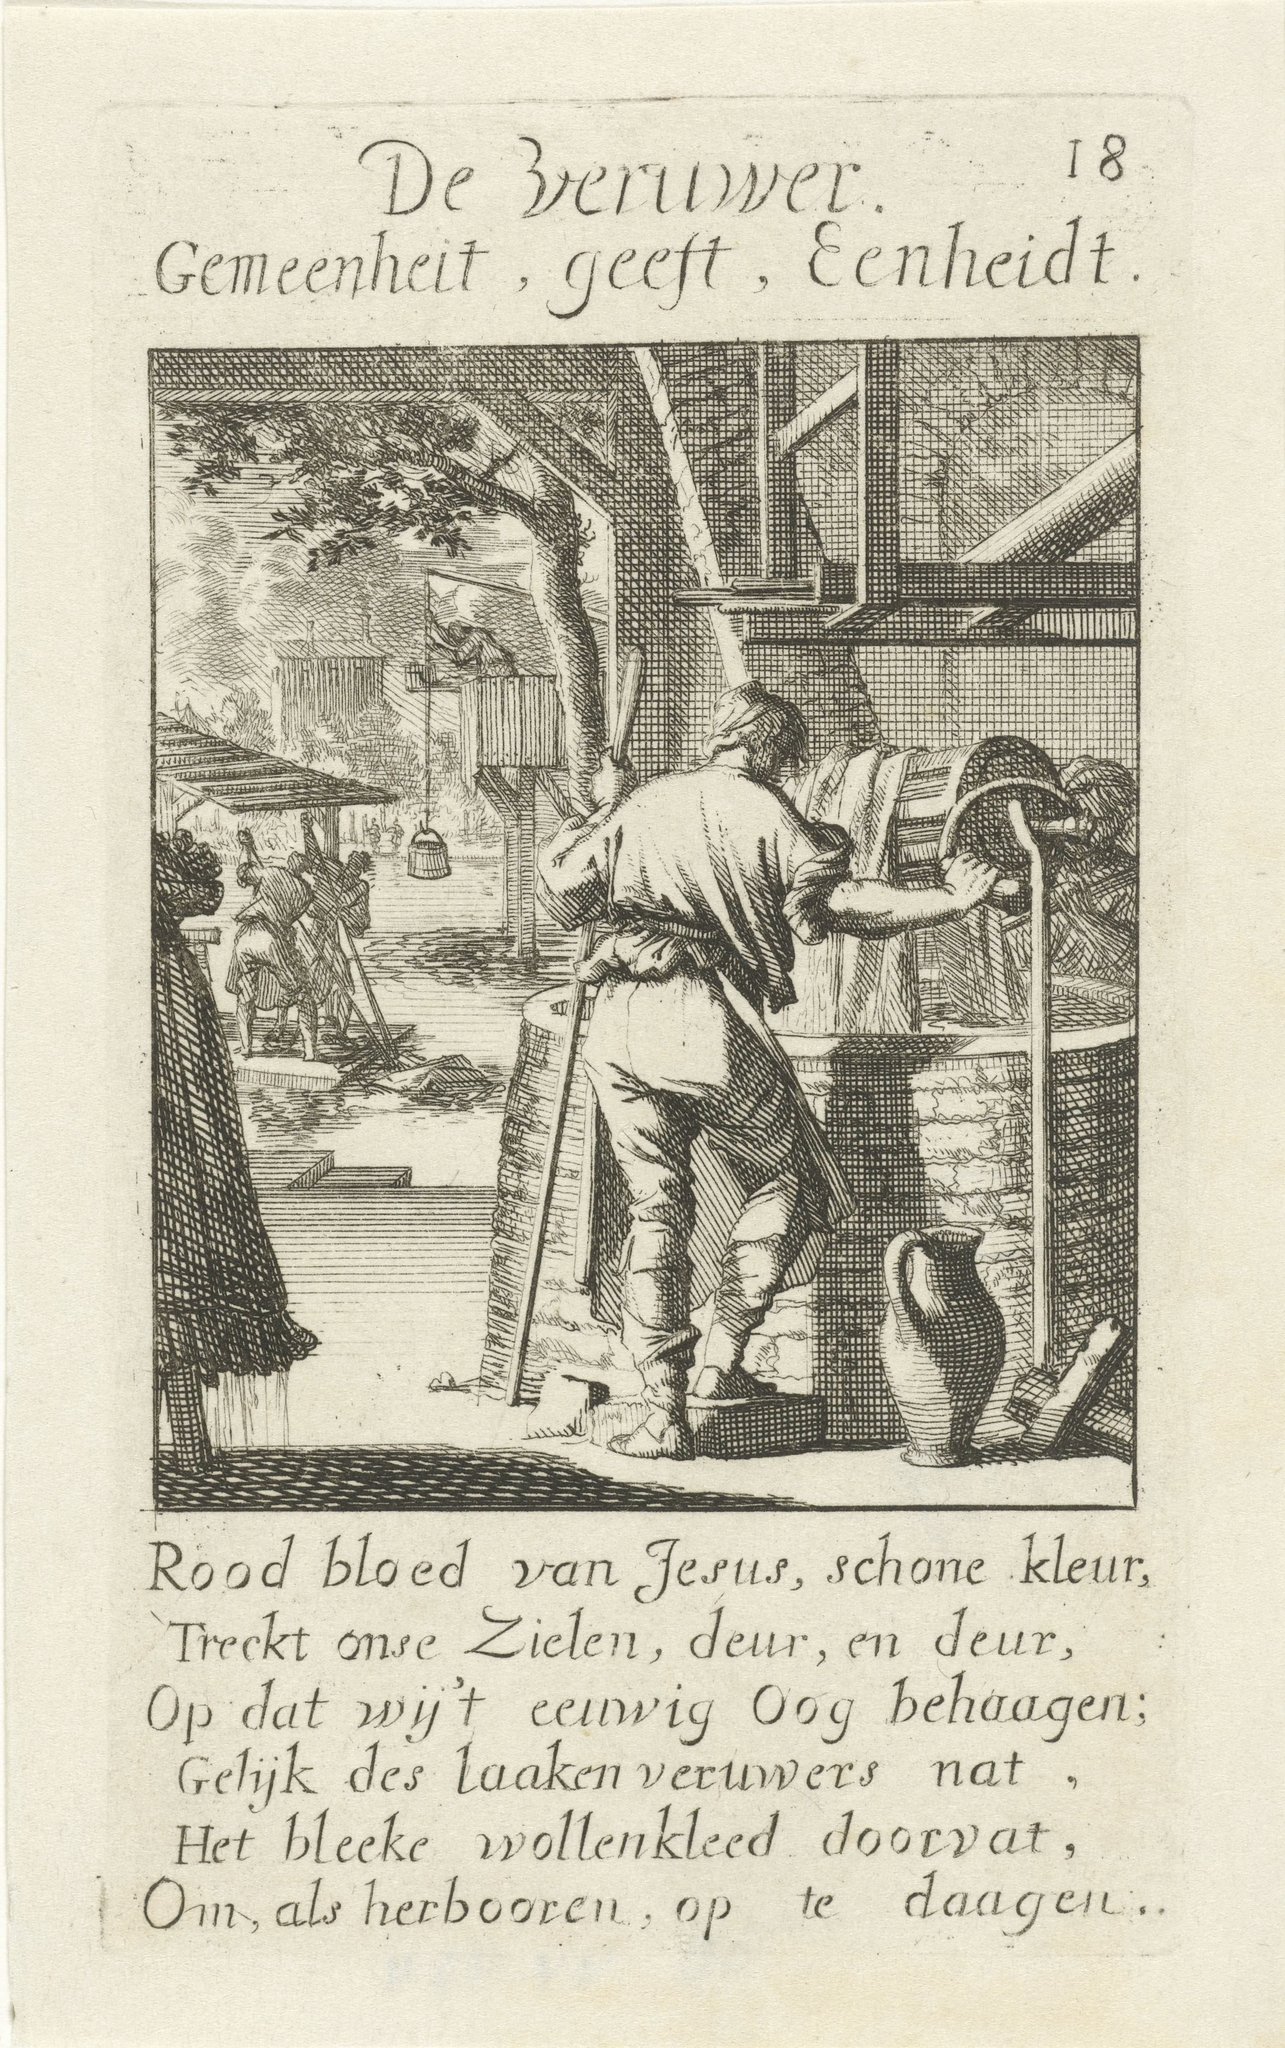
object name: print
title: De Veruwer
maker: jan luyken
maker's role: draughtsman, print maker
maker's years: 1649-1712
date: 1694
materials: paper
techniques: etching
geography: amsterdam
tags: dyeing of cloth, handicrafts, craftsman at work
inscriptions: collector's mark: Lugt 2228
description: Maakt deel uit van de 100-delige serie beroepsprenten van Jan en Caspar Luyken, getiteld: Het menselyk bedryf. S.l.s.n., 1694 (eerste druk).